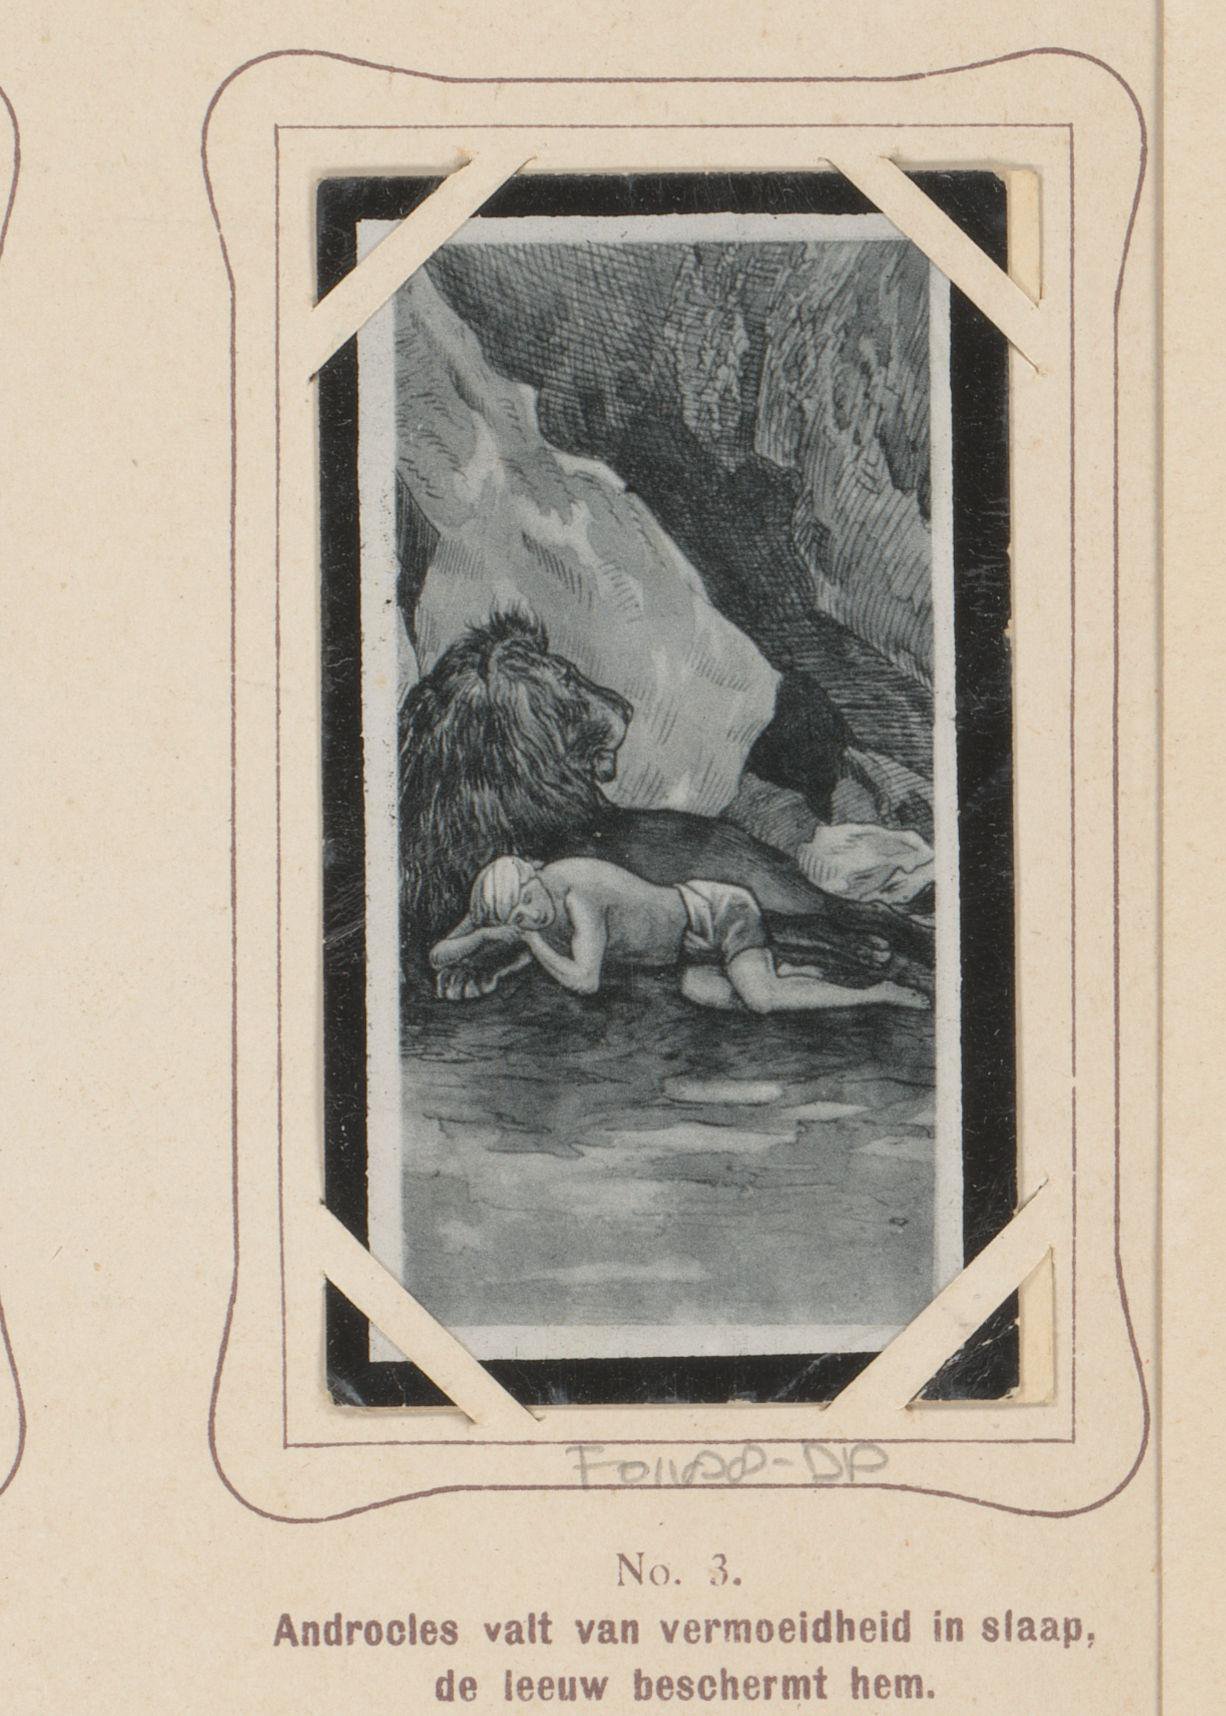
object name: album leaf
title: Reproductie van een tekening van Androclus met de leeuw, slapend in een grot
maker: Anonymous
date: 1906-1907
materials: paper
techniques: photograph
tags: (story of) androclus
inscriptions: inscription: ‘No. 3./ Androcles valt van vermoeidheid in slaap, de leeuw beschermt hem.’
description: Deze prent maakt deel uit van een album.